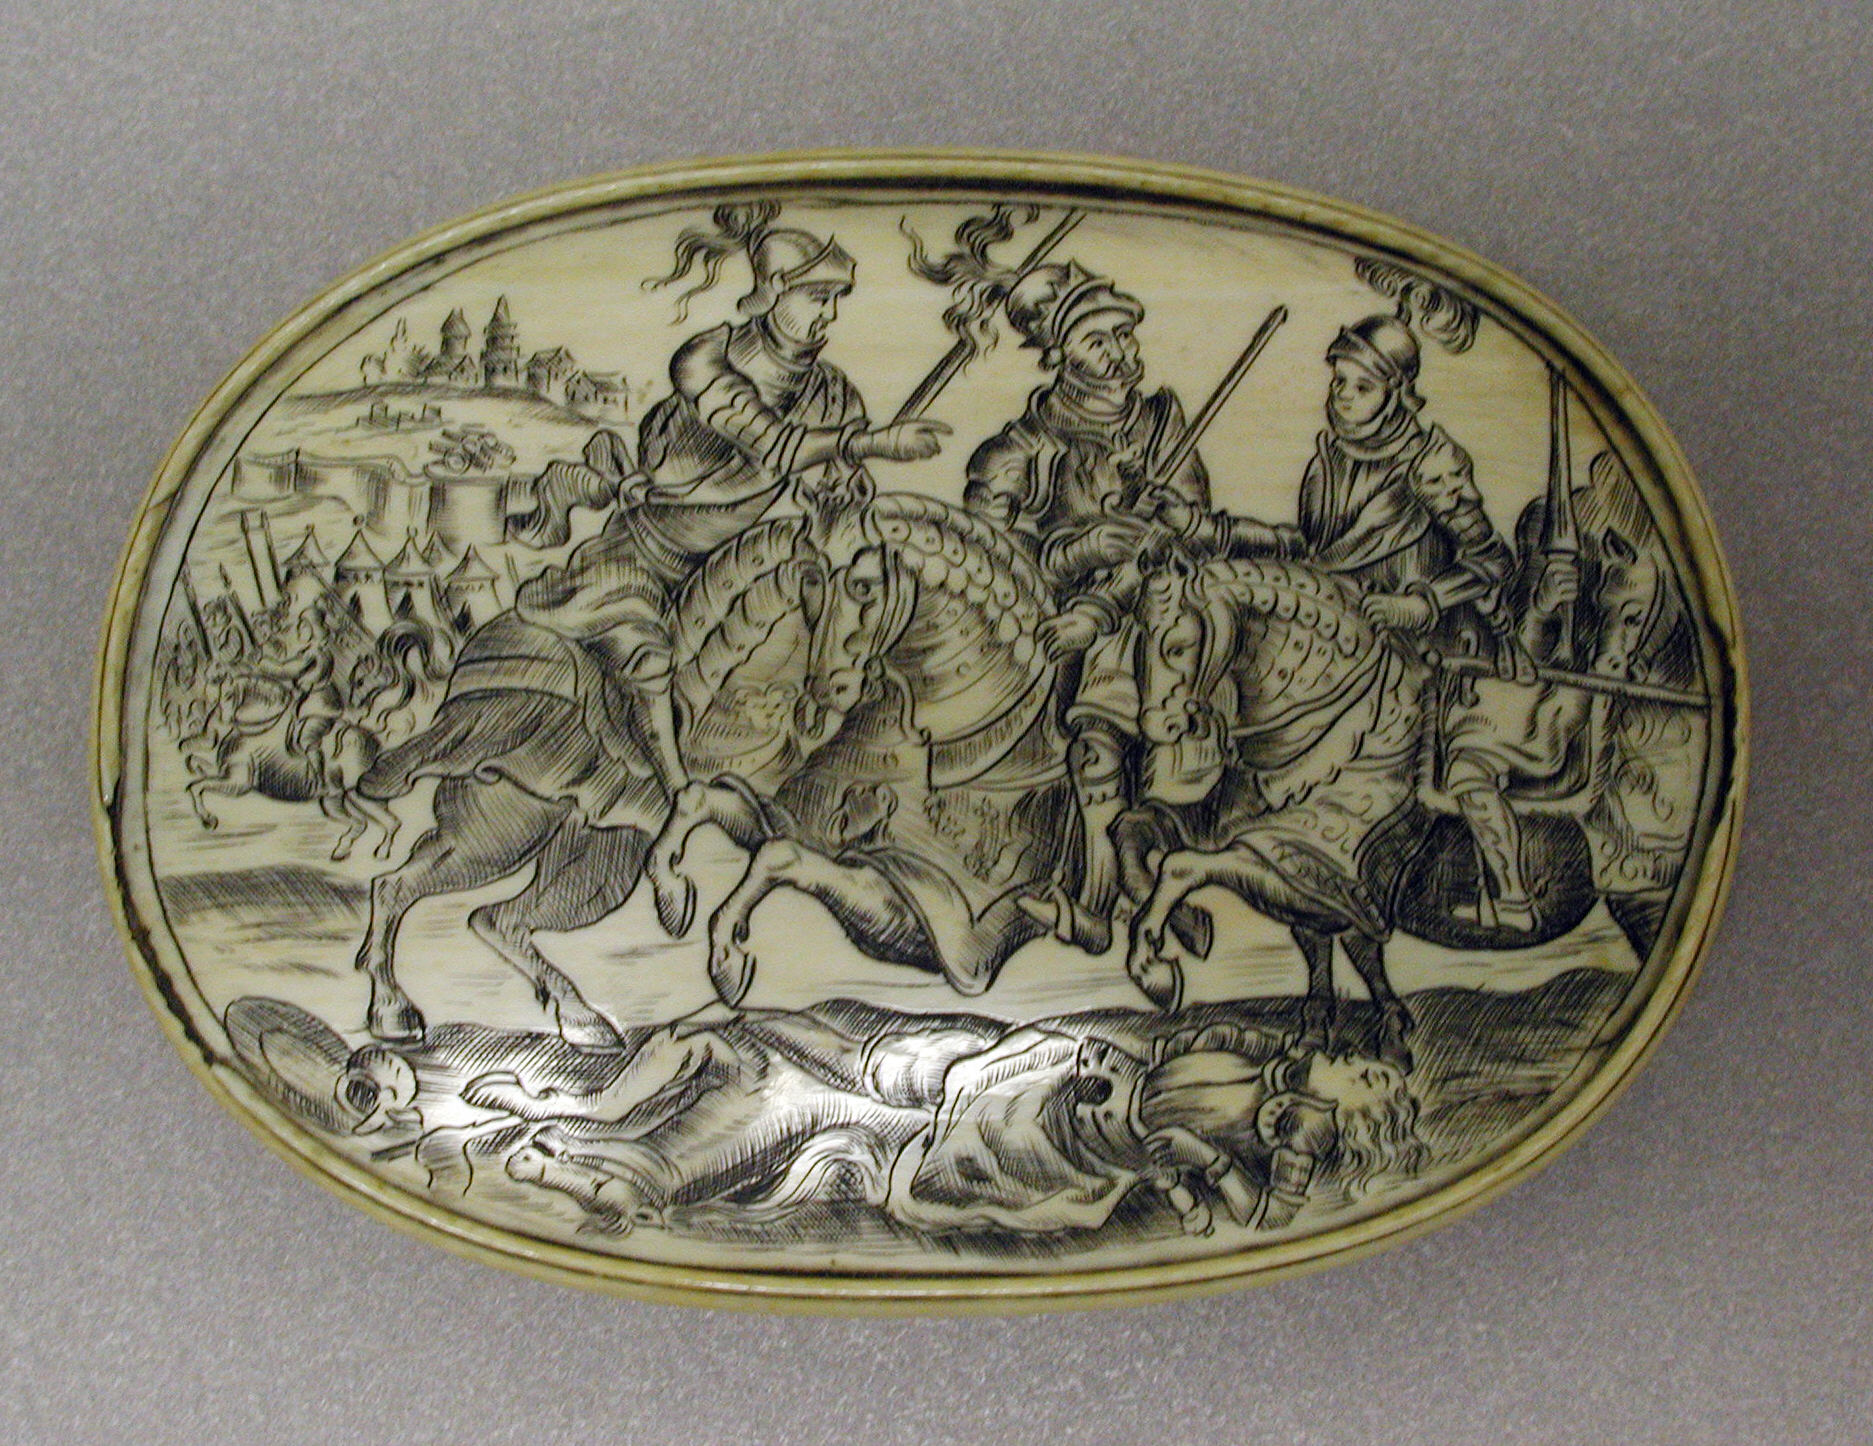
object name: box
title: The Battle of Pavia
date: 1700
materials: ivory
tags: battles,soldiers,swords,men,horses